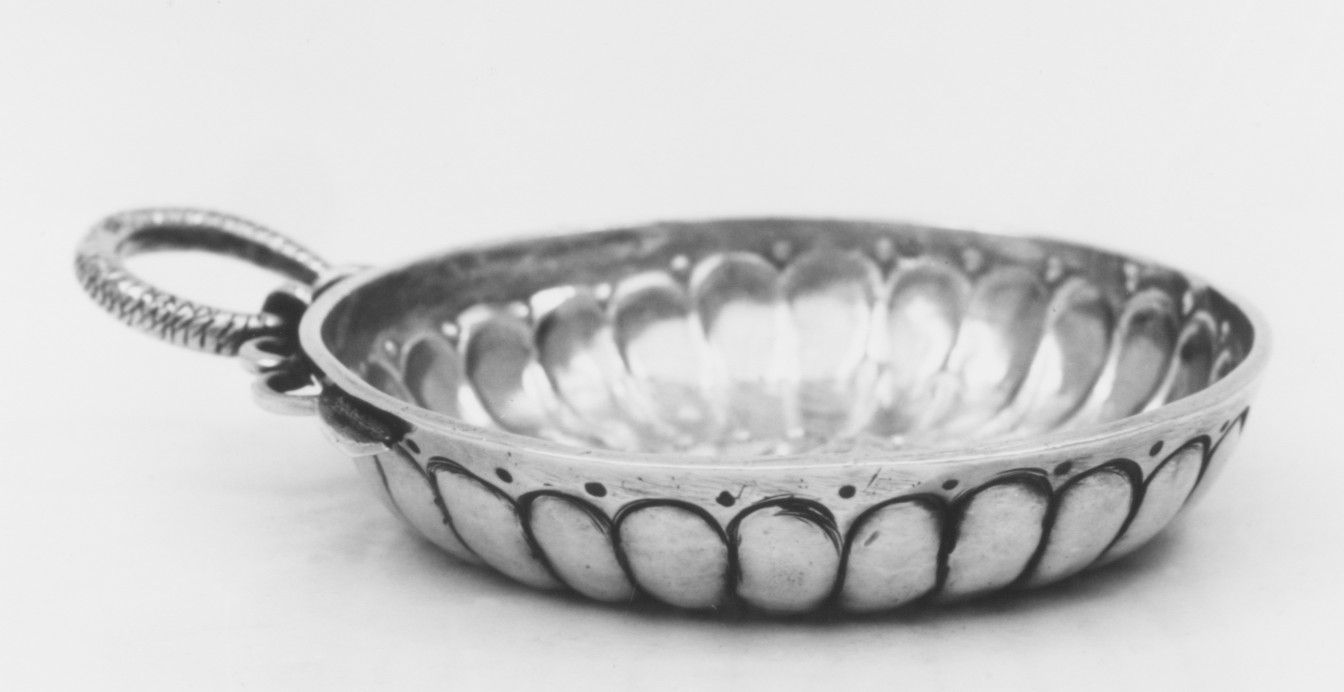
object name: wine taster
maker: nicolas bouton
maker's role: maker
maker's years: 1697-1769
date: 1734-1766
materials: silver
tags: men